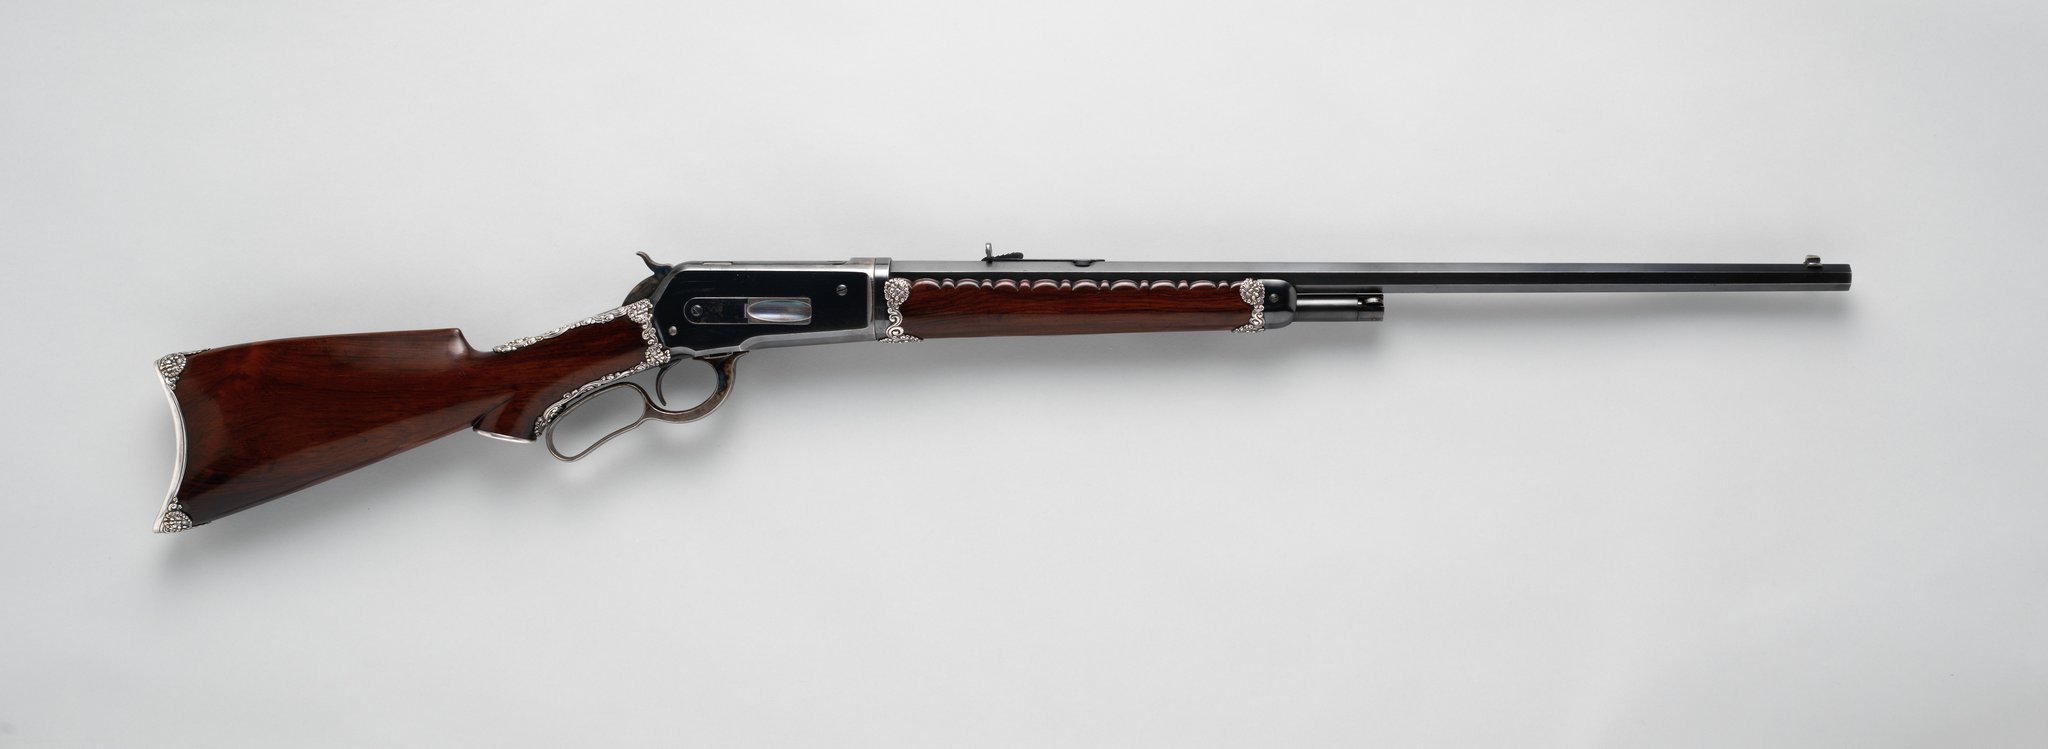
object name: rifle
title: Winchester Model 1886 Takedown Rifle decorated by Tiffany & Co. (serial no. 120528)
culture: american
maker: winchester repeating arms company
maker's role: manufacturer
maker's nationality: american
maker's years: 1866-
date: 1899-1900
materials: silver, steel, wood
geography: united states